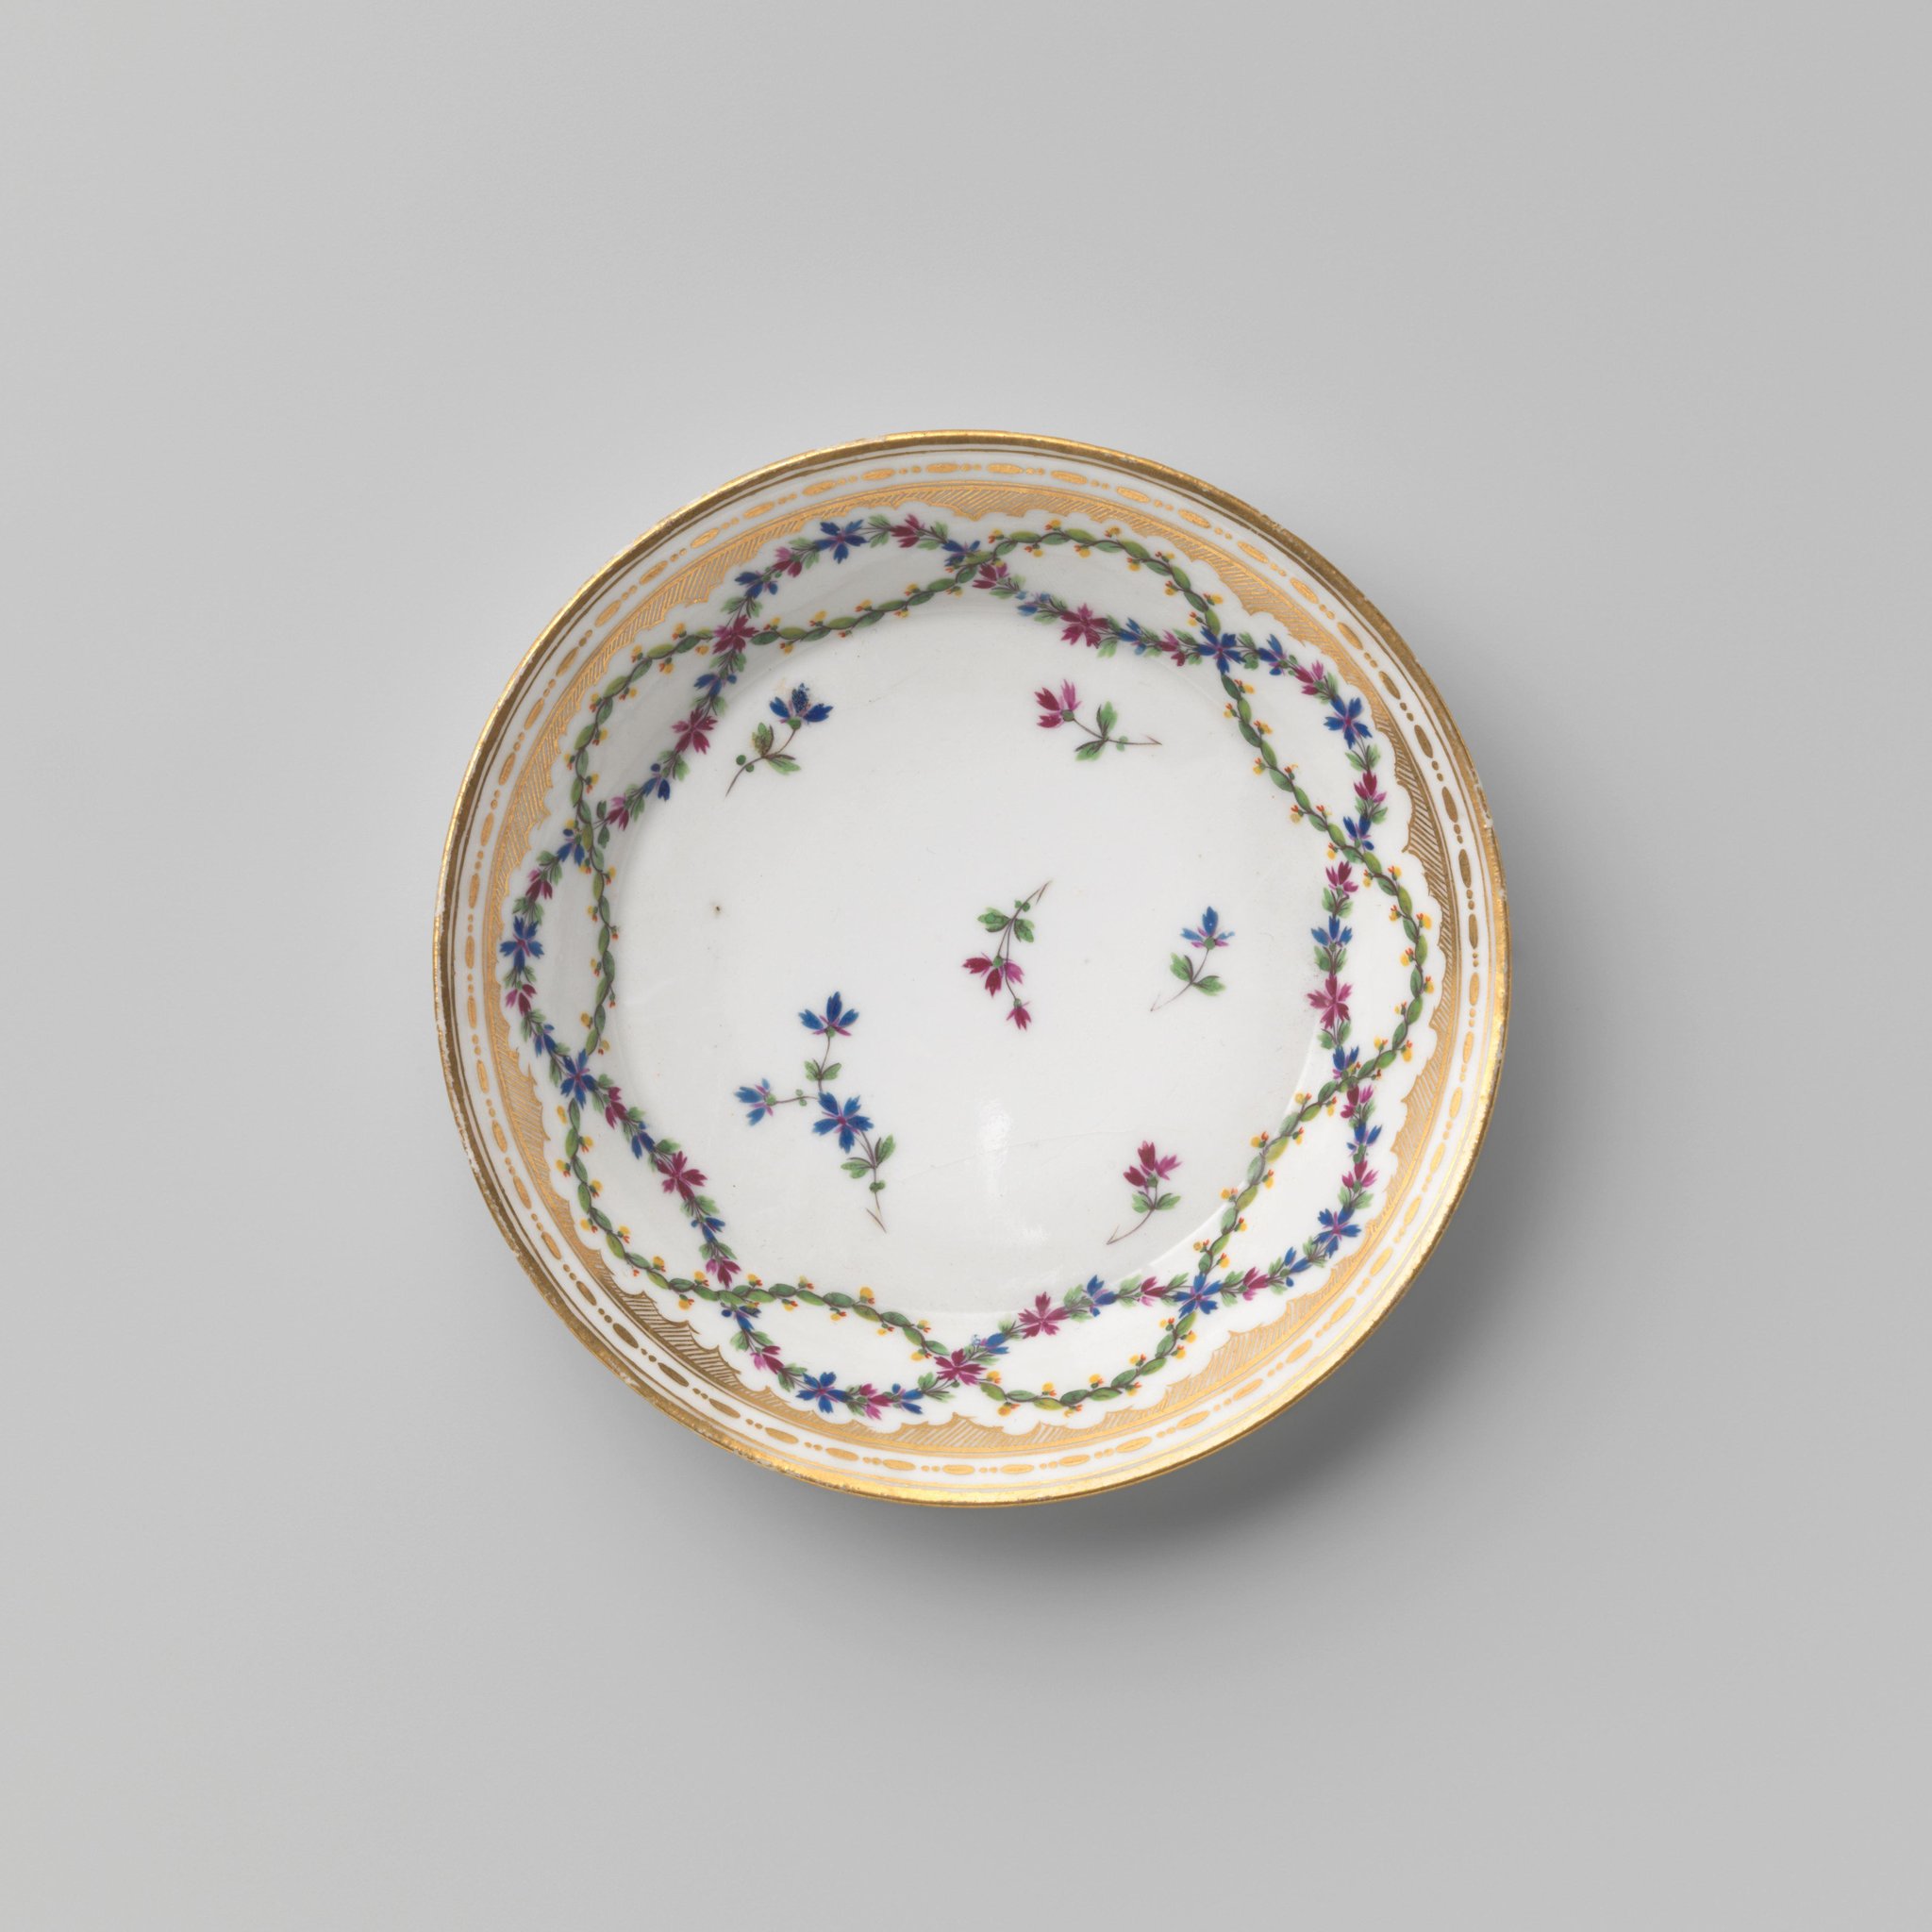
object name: platter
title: Saucer with floral scrolls and flower sprays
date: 1775-1790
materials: glaze, gold, paint, porcelain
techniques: firing, gilding, turning, vitrification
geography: clignancourt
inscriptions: mark: ‘LSX’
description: Schotel van porselein met een rechte wand, beschilderd op het glazuur in blauw, rood, roze, groen, geel, paars en goud. Op het plat bloemtakken. De wand met twee elkaar kruisende bloemranken met daarboven een decoratieve band. Gouden rand. Gemerkt op de onderzijde met het monogram 'LSX'.